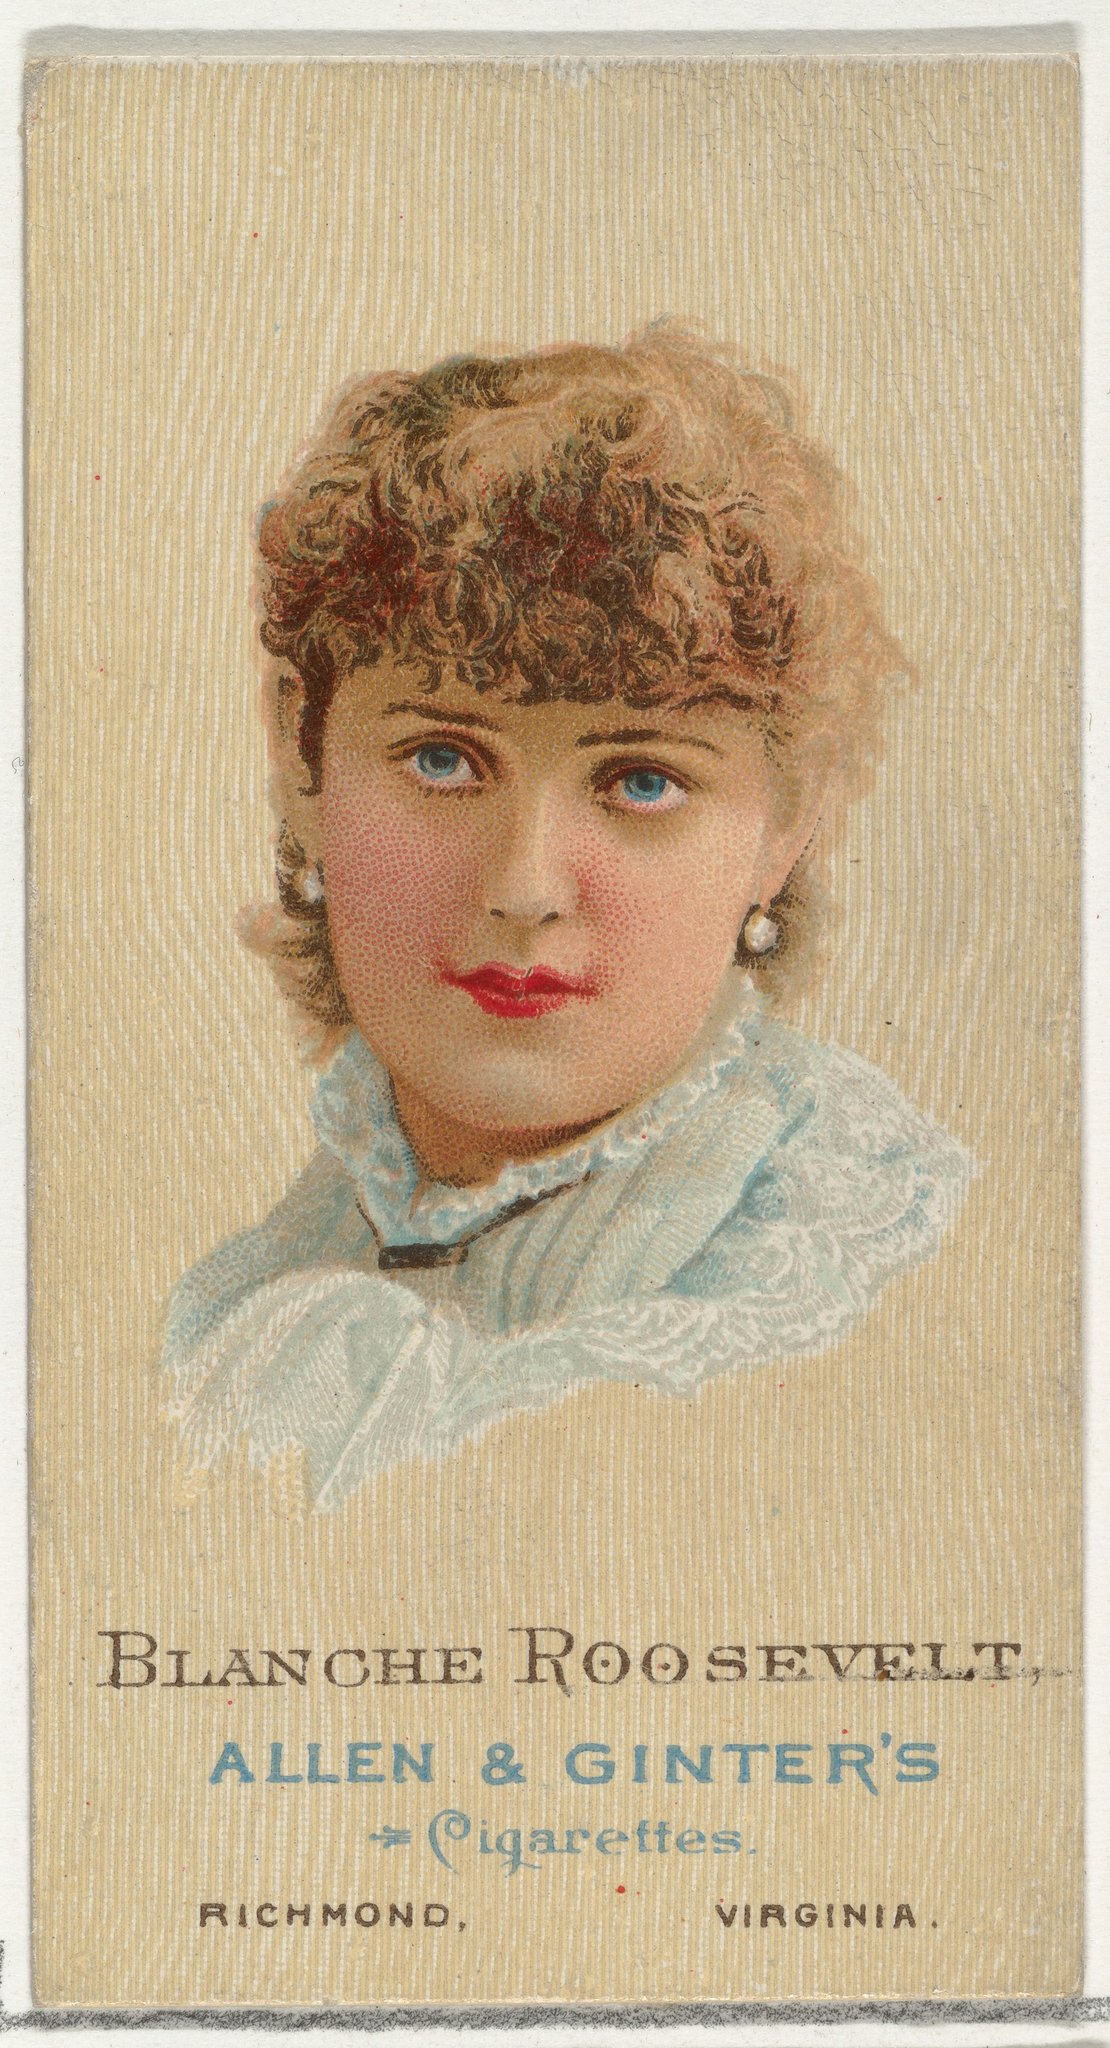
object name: print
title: Blanche Roosevelt, from World's Beauties, Series 2 (N27) for Allen & Ginter Cigarettes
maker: allen & ginter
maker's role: publisher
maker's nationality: american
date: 1888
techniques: color lithograph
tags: women